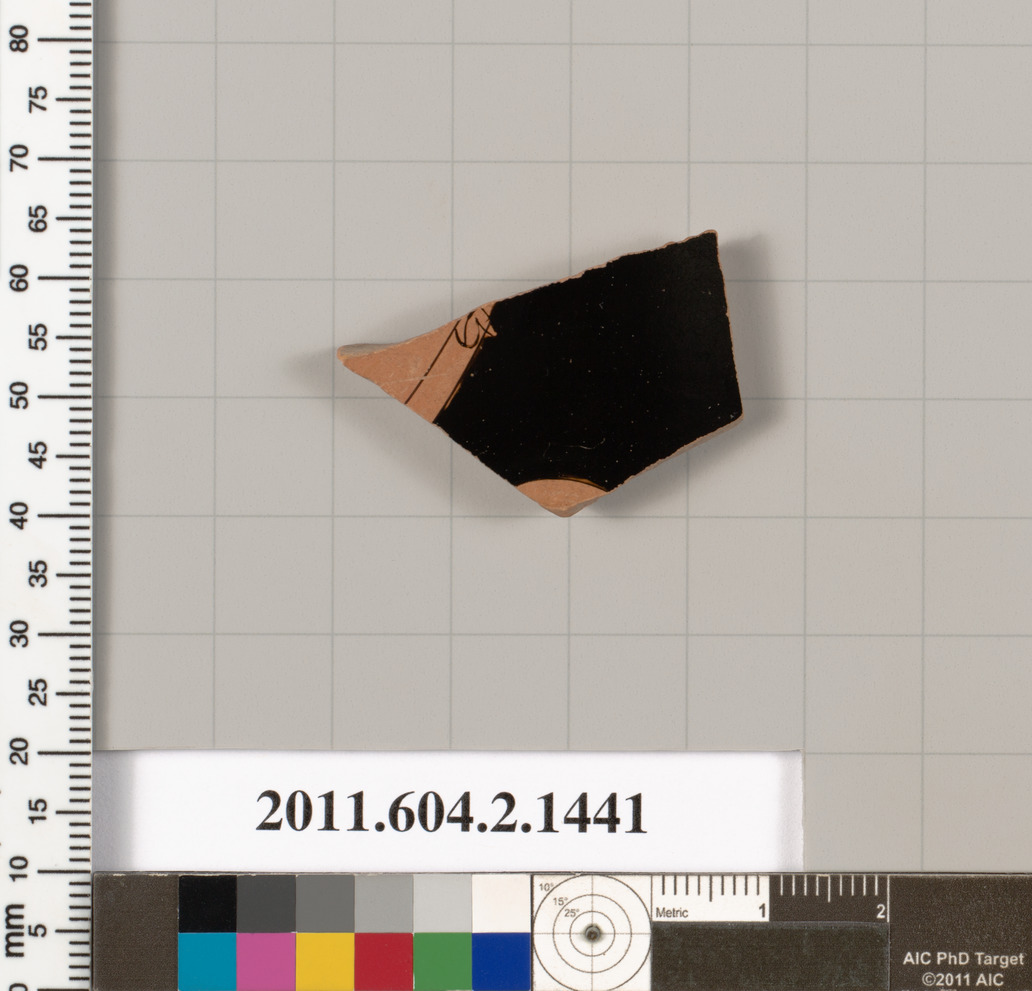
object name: skyphos fragment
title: Terracotta fragment of a skyphos (deep drinking cup)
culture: greek, attic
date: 475-451 BCE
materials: terracotta